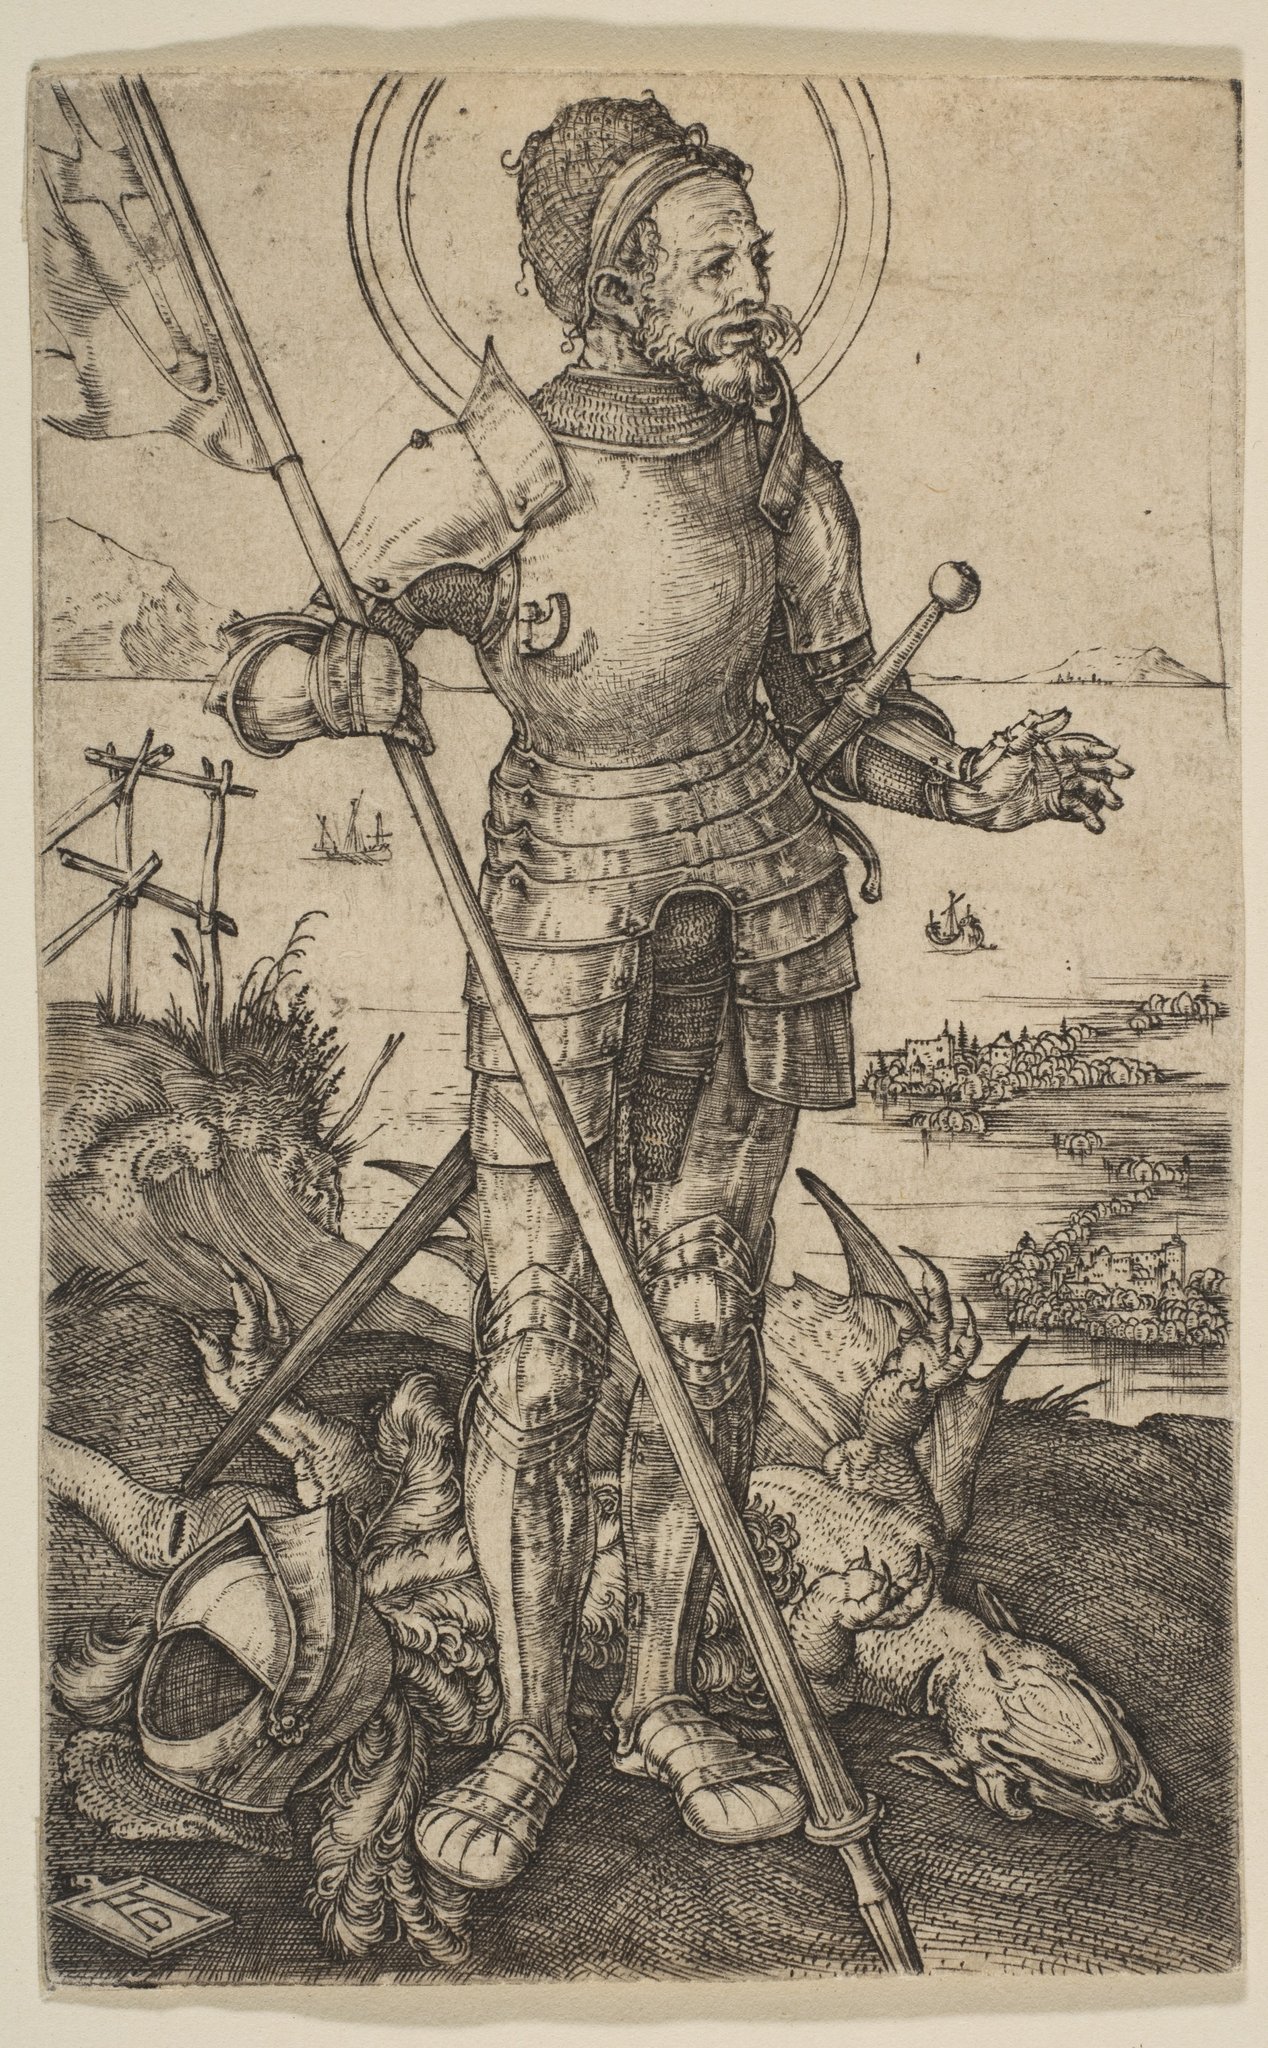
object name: print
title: Saint George Standing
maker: albrecht dürer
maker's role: artist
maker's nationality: german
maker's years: 1471-1528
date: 1502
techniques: engraving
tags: saint george,flags